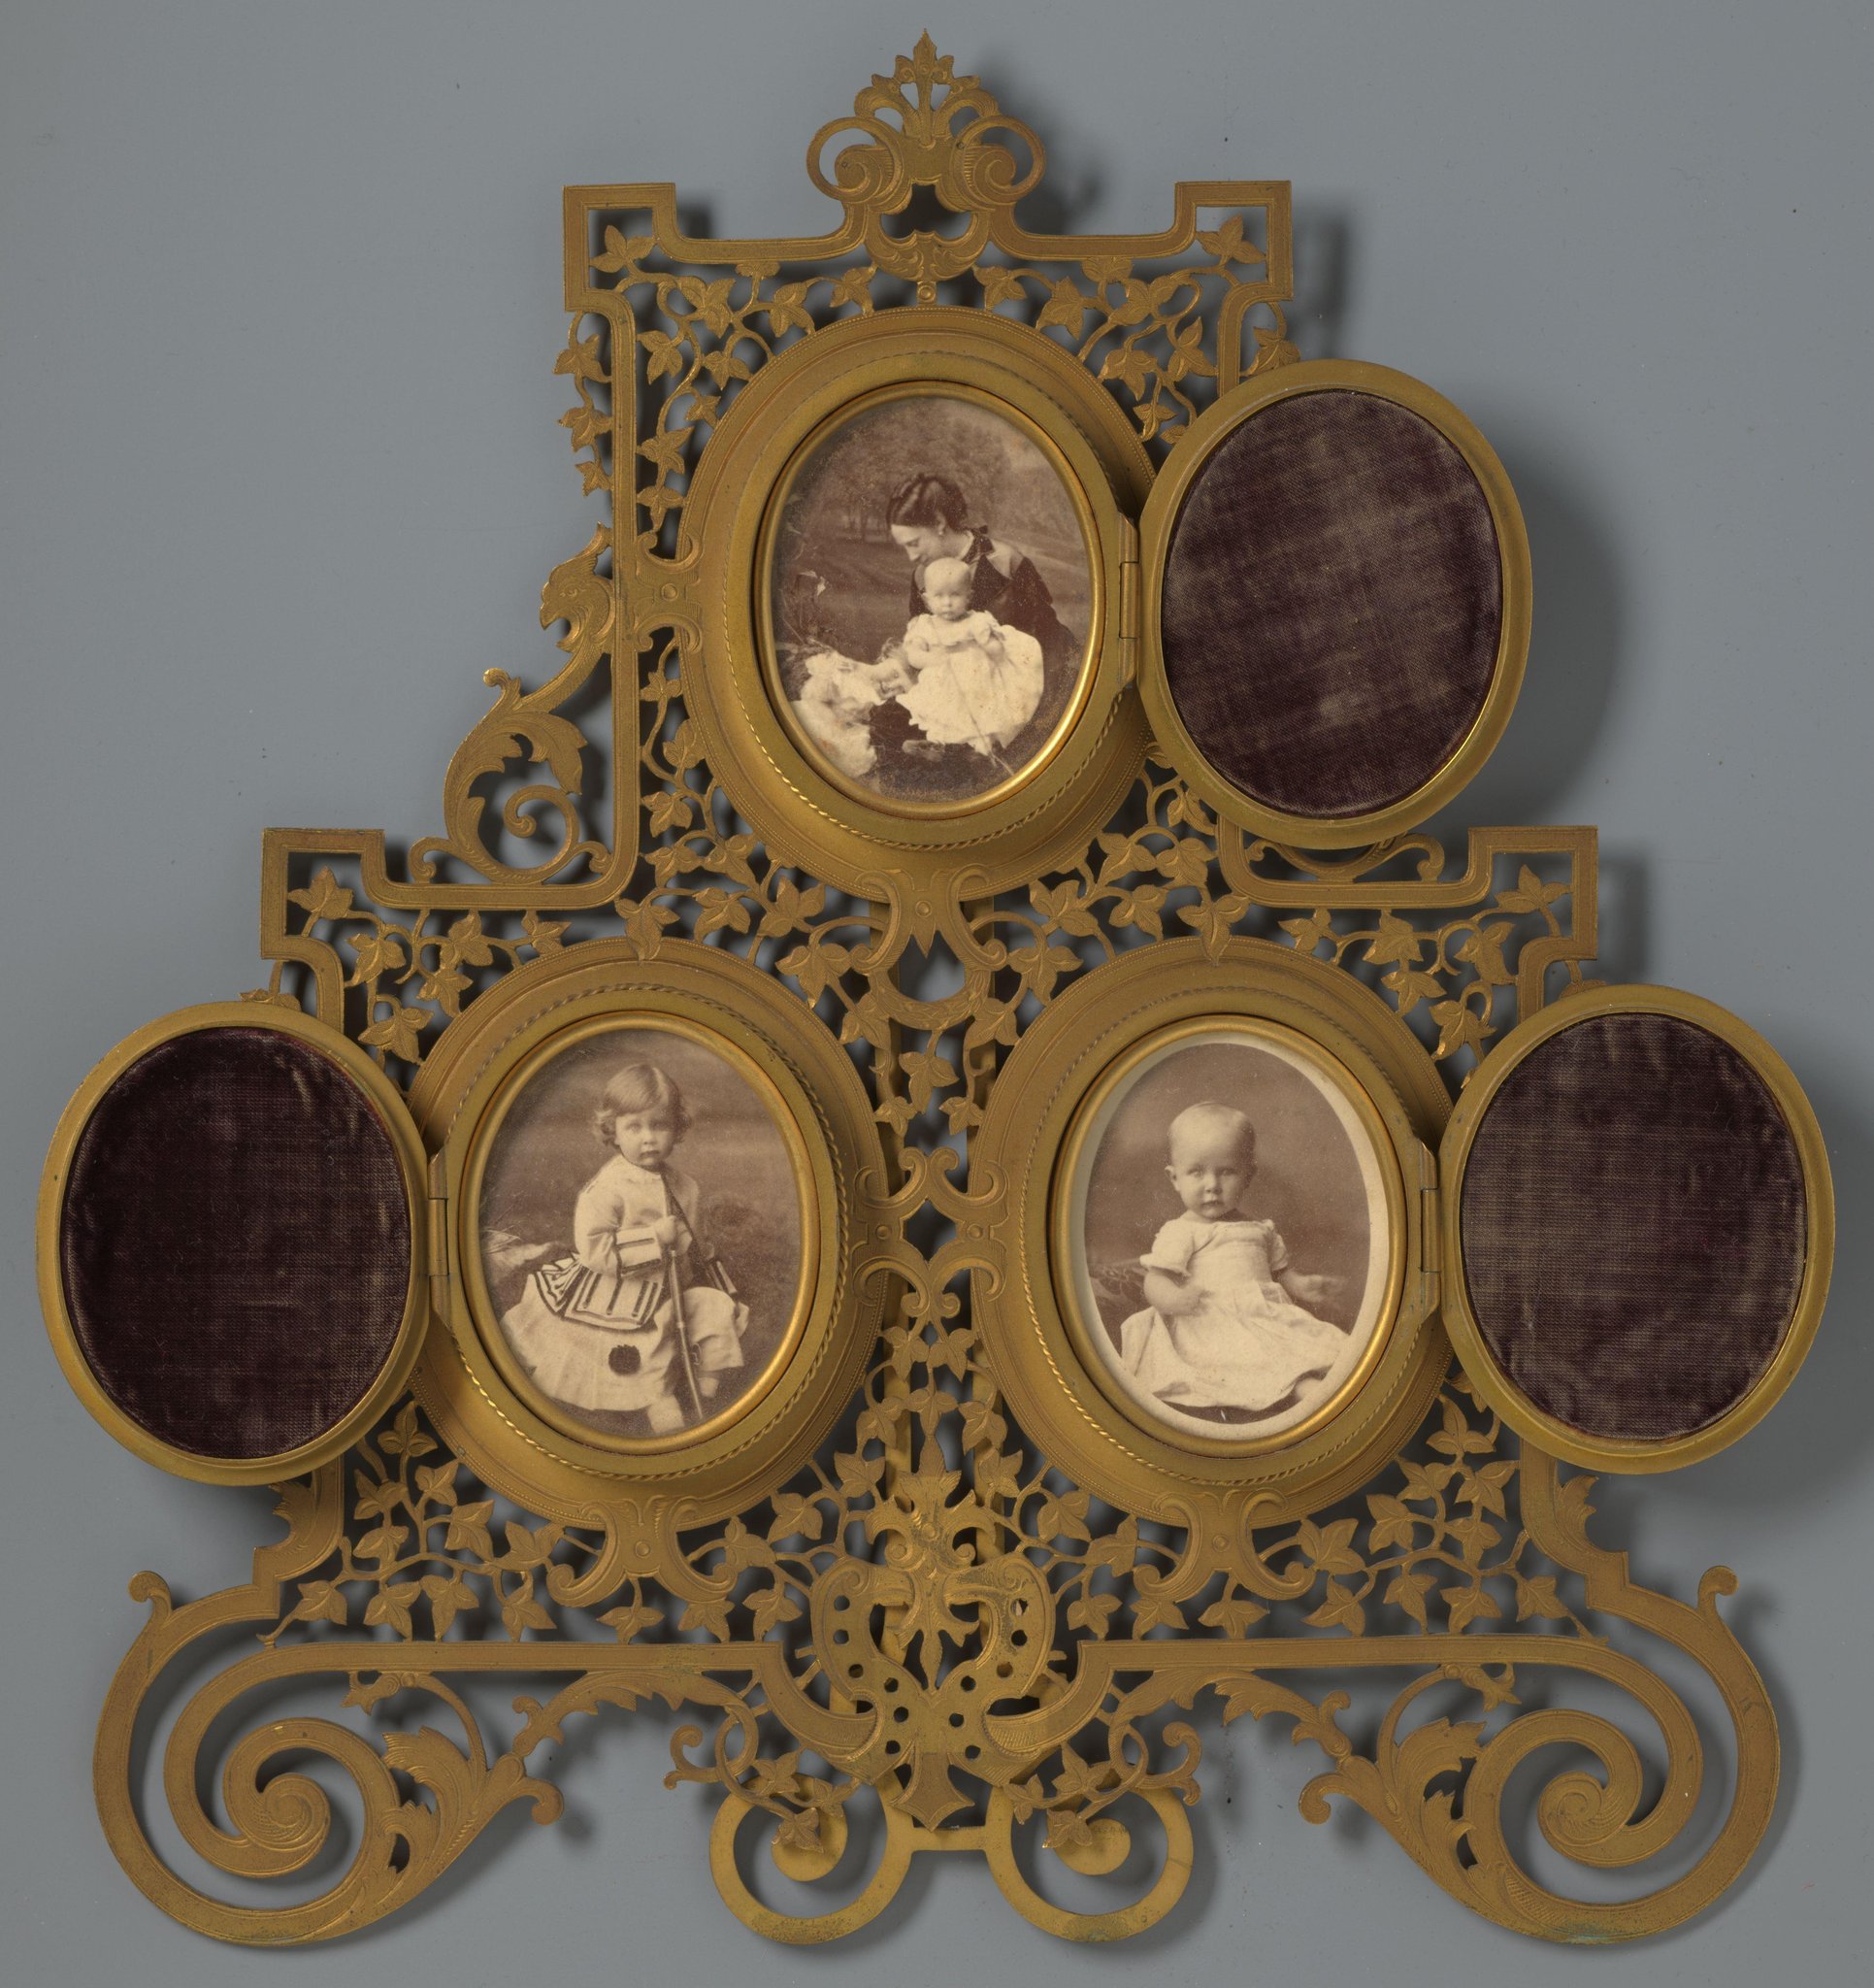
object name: photograph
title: Standaard met drie foto-medaillons, portretten van prinses Marie van Oranje-Nassau en haar kinderen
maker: bernardus bruining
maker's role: fotograaf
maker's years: 1834-1900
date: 1875-1880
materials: brass, cardboard, paint, paper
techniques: albumen print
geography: the hague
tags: mother and child(ren), woman and child(ren) (family group)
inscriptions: number: ‘R 4118 D.V.R.K.’